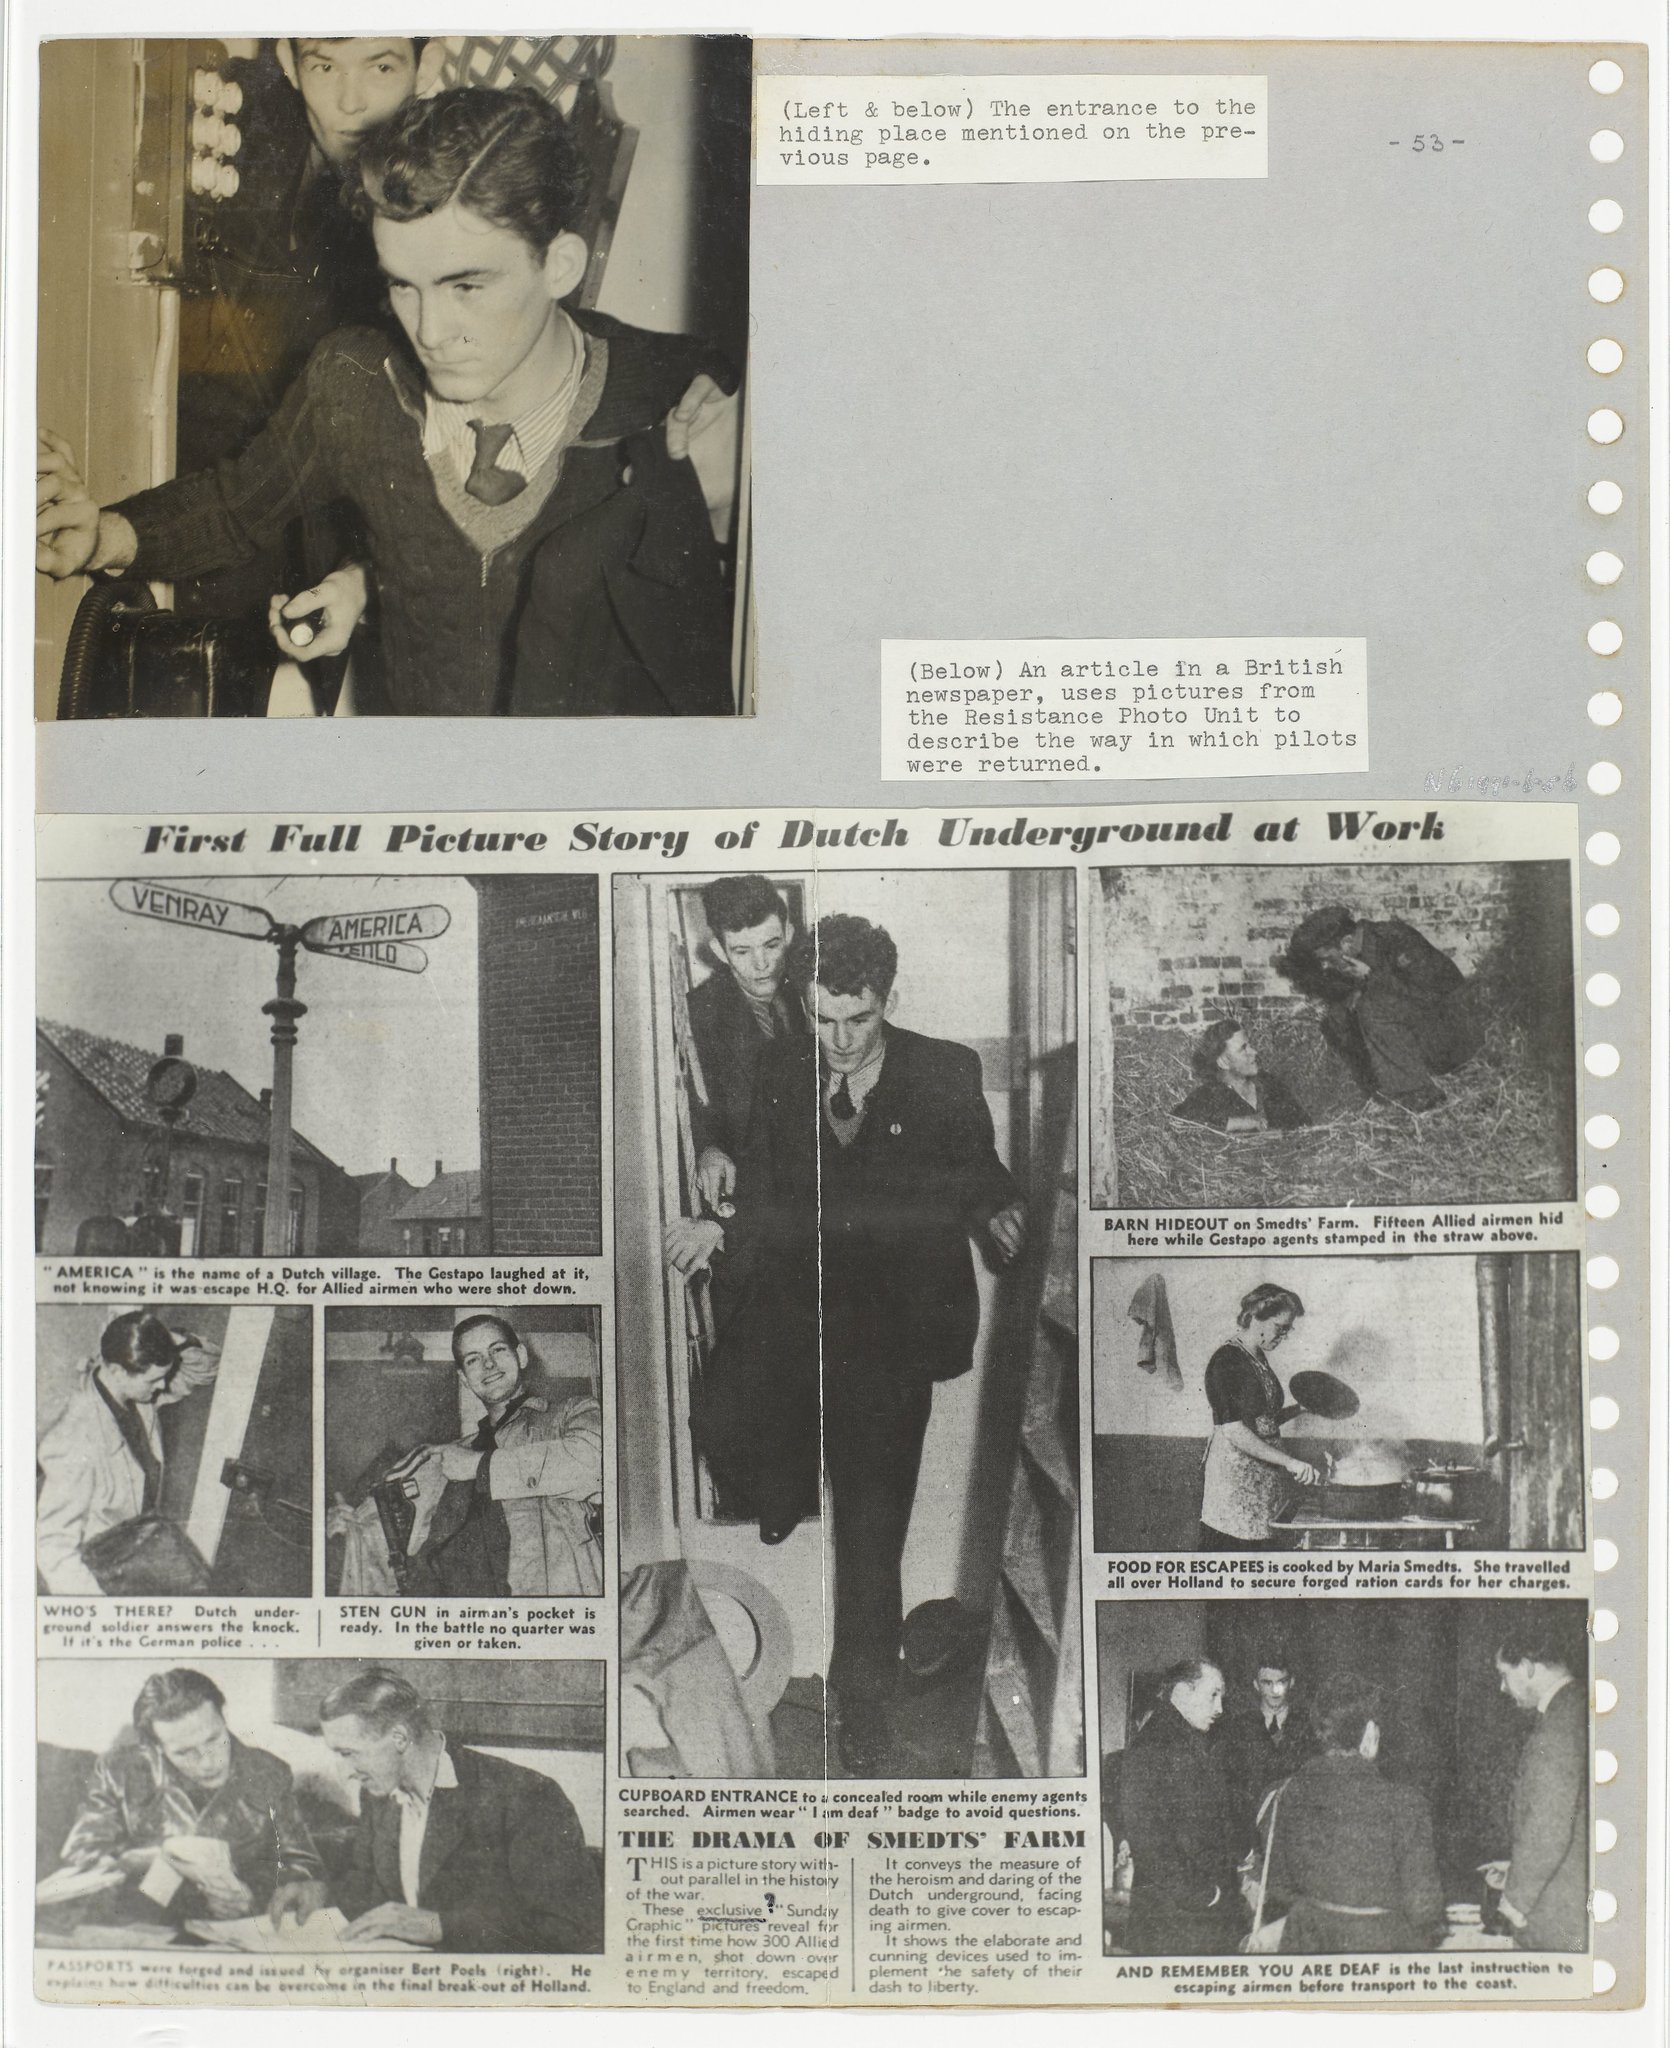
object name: newspaper clipping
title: Ondergedoken Amerikaanse piloten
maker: Anonymous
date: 1944-1945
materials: paper, plastic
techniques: photography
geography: amsterdam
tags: tonny van renterghem, berlin, fritz kahlenberg, underground movement, partisans, newspaper, news-sheet, netherlands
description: Een foto van ondergedoken Amerikaanse piloten. Twee Amerikaanse piloten ondergedoken in Amsterdam in de ingang van hun schuilplaats. Onder: pagina uit een Engelse krant met foto's van het verzet van de onderduiksituaties van piloten.